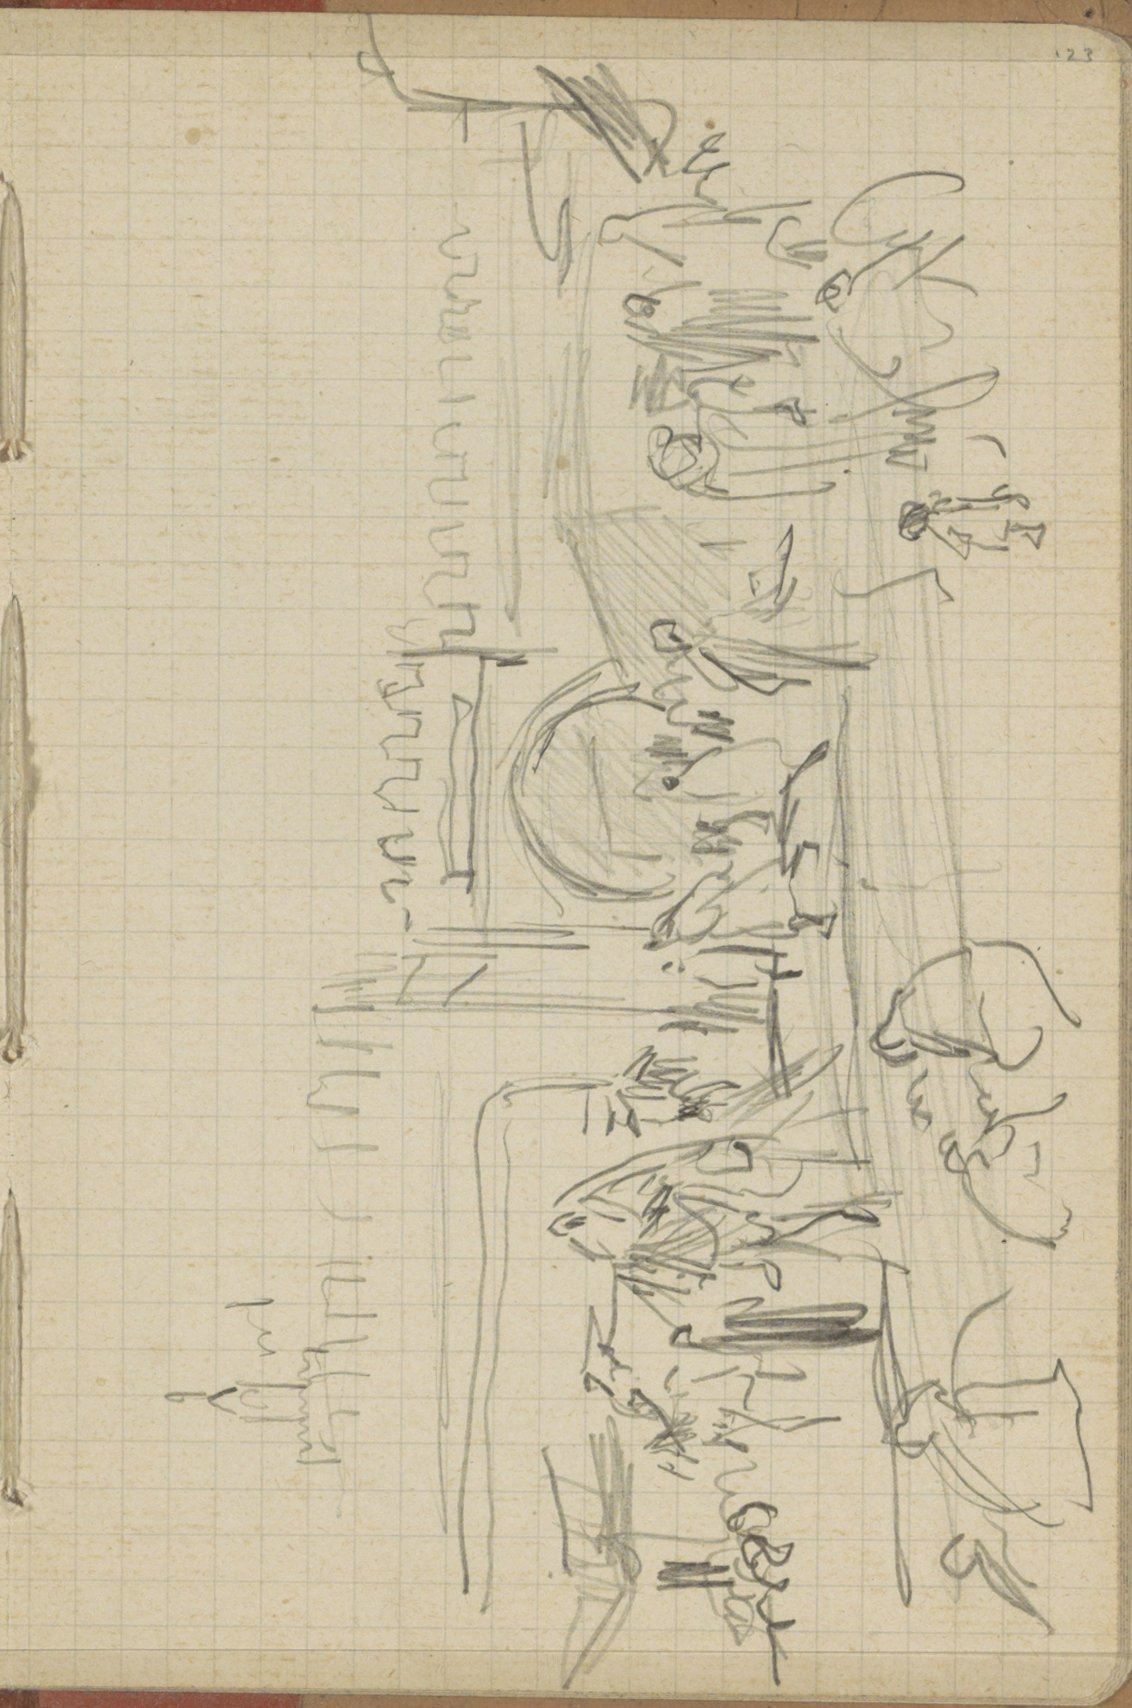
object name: sketchbook leaf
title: Figuren op een straat met een poort en een stadsmuur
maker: marius bauer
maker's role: draughtsman, print maker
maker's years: 1867-1932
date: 1909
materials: pencil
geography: tunisia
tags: gate, entrance, walls ~ fortified city, street (+ city(-scape) with figures, staffage)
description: Mogelijk de stad Kairouan. Pagina 123 uit een schetsboek met 67 bladen.